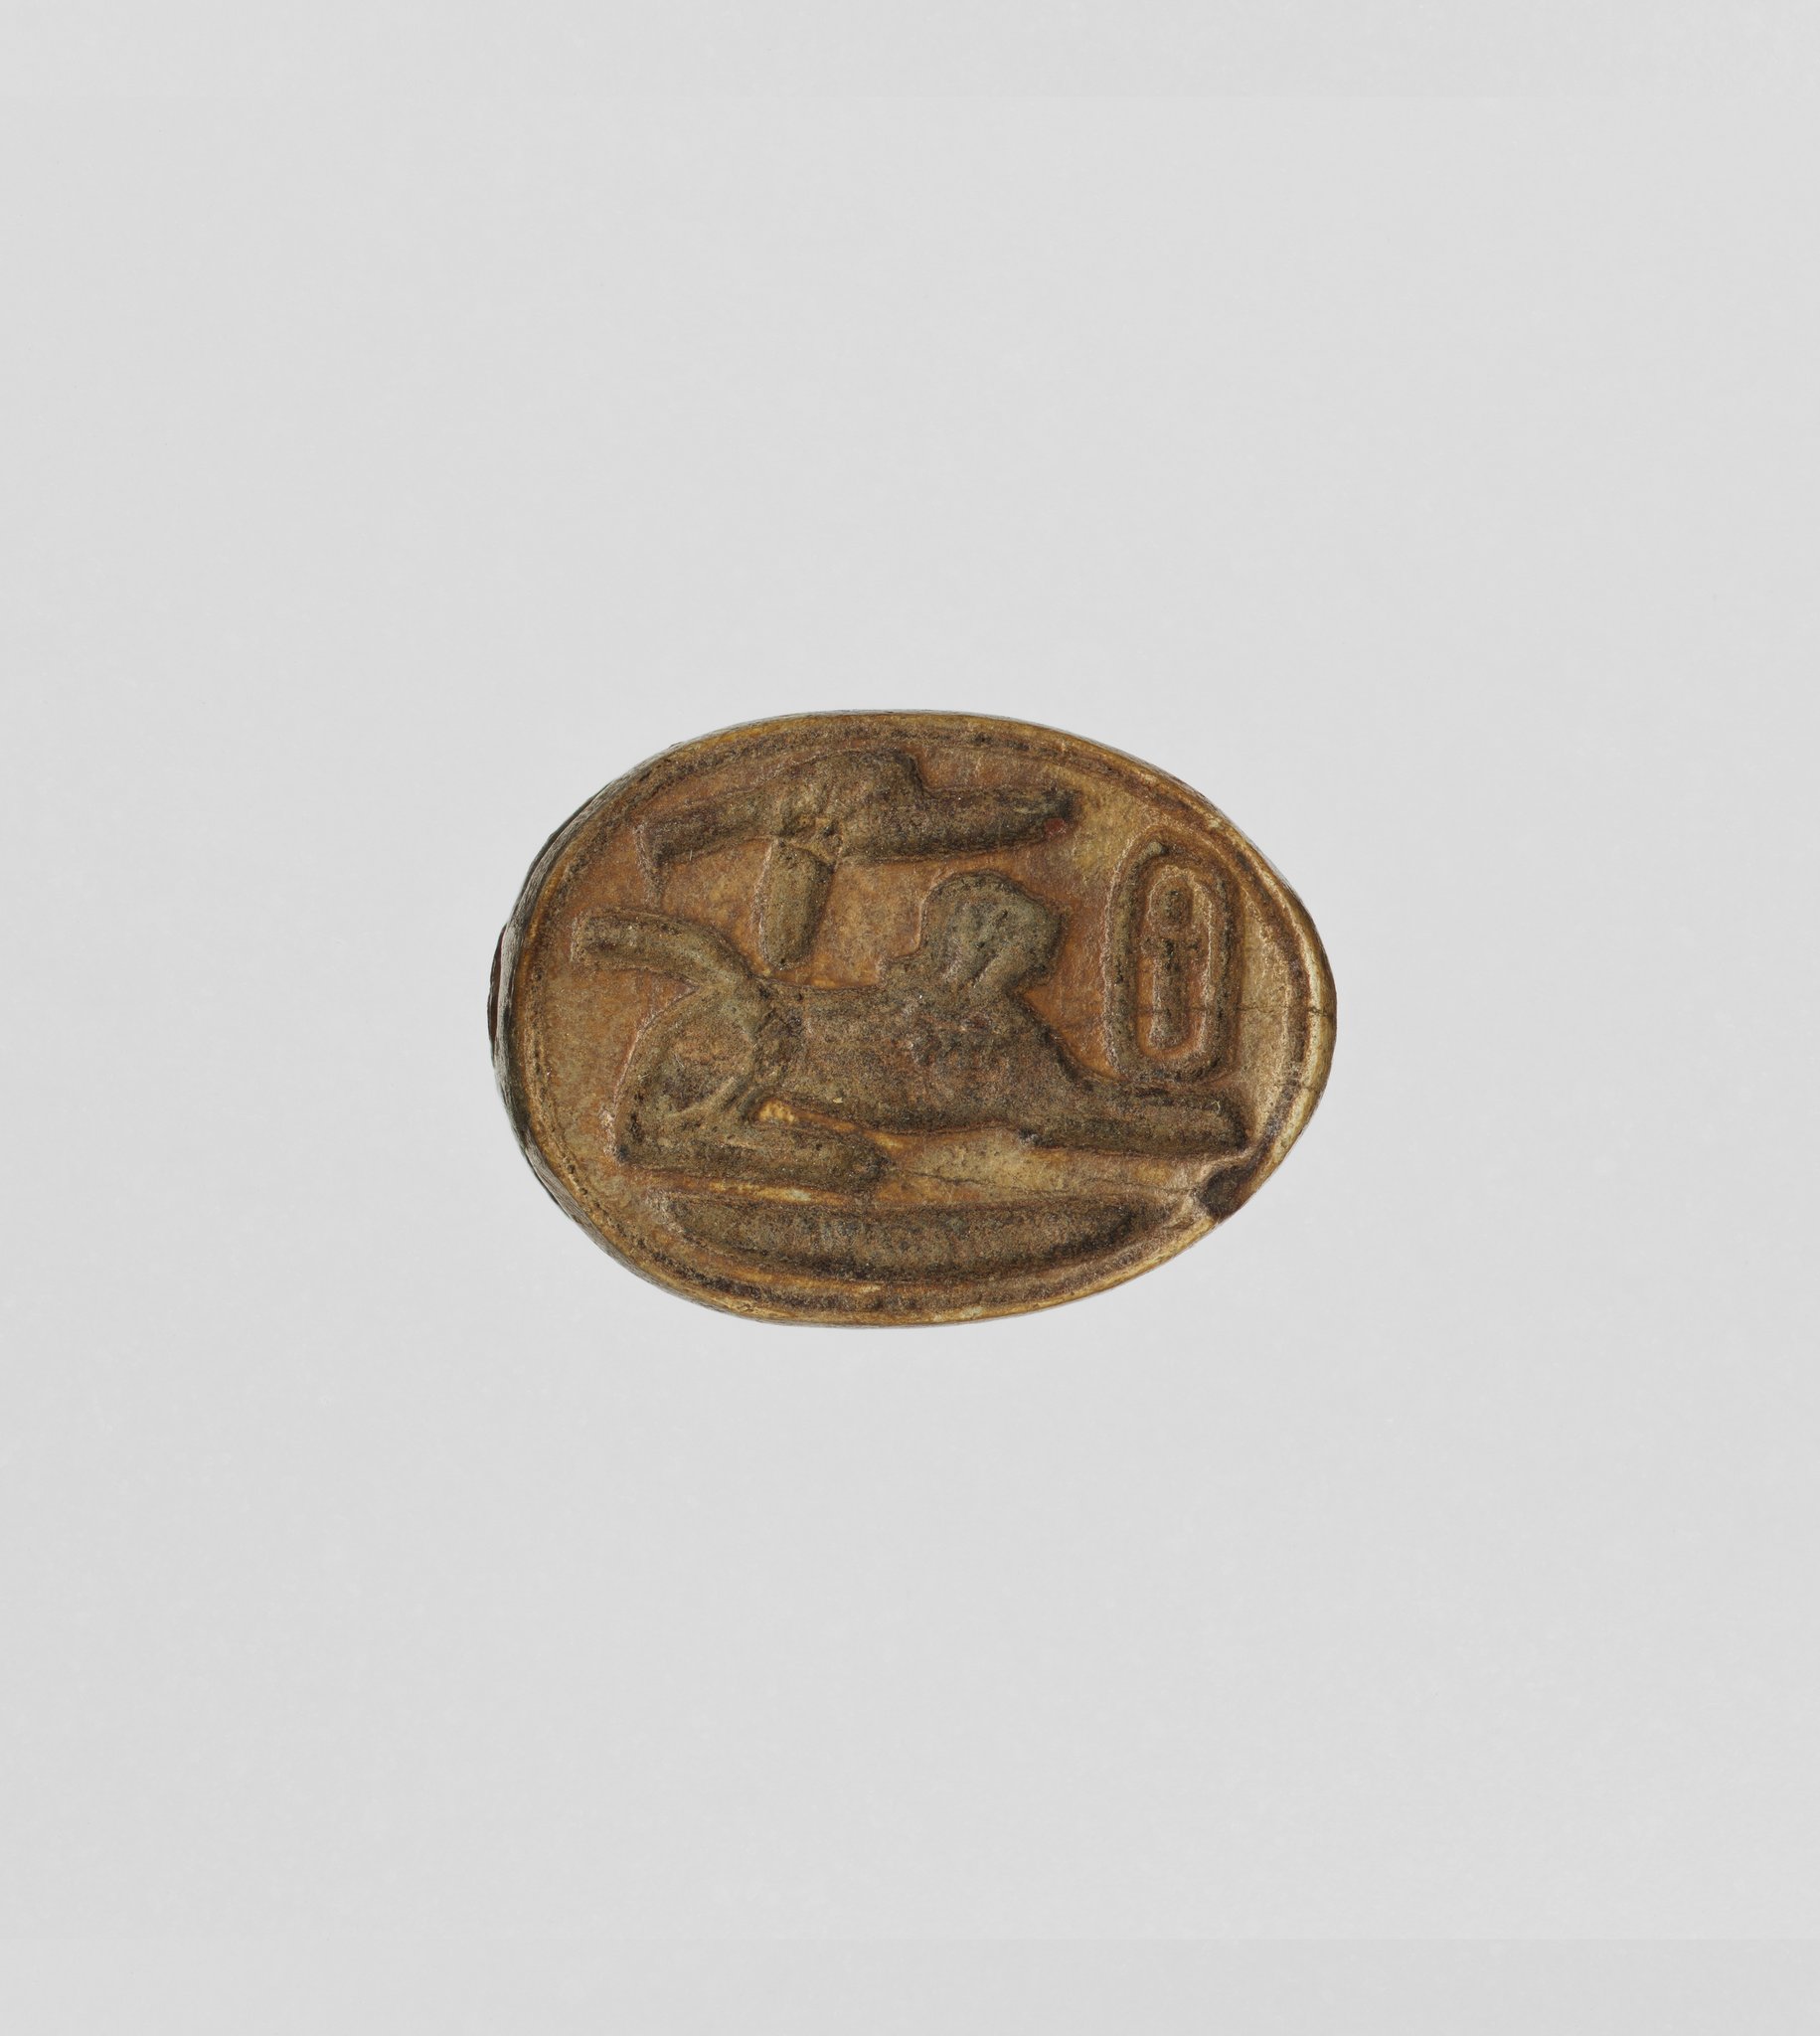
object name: scaraboid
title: Scarab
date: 1295-1070 BCE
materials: stone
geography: egypt